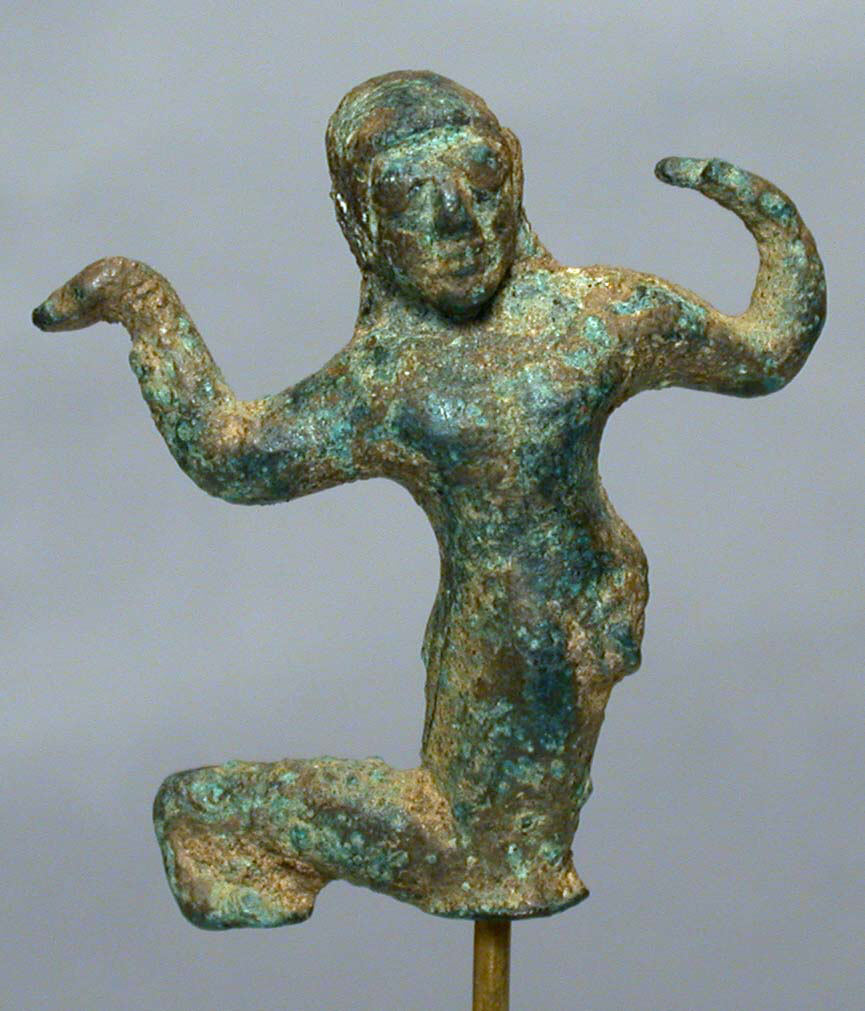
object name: statuette of a dancer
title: Bronze statuette of a dancer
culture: etruscan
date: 400-301 BCE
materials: bronze